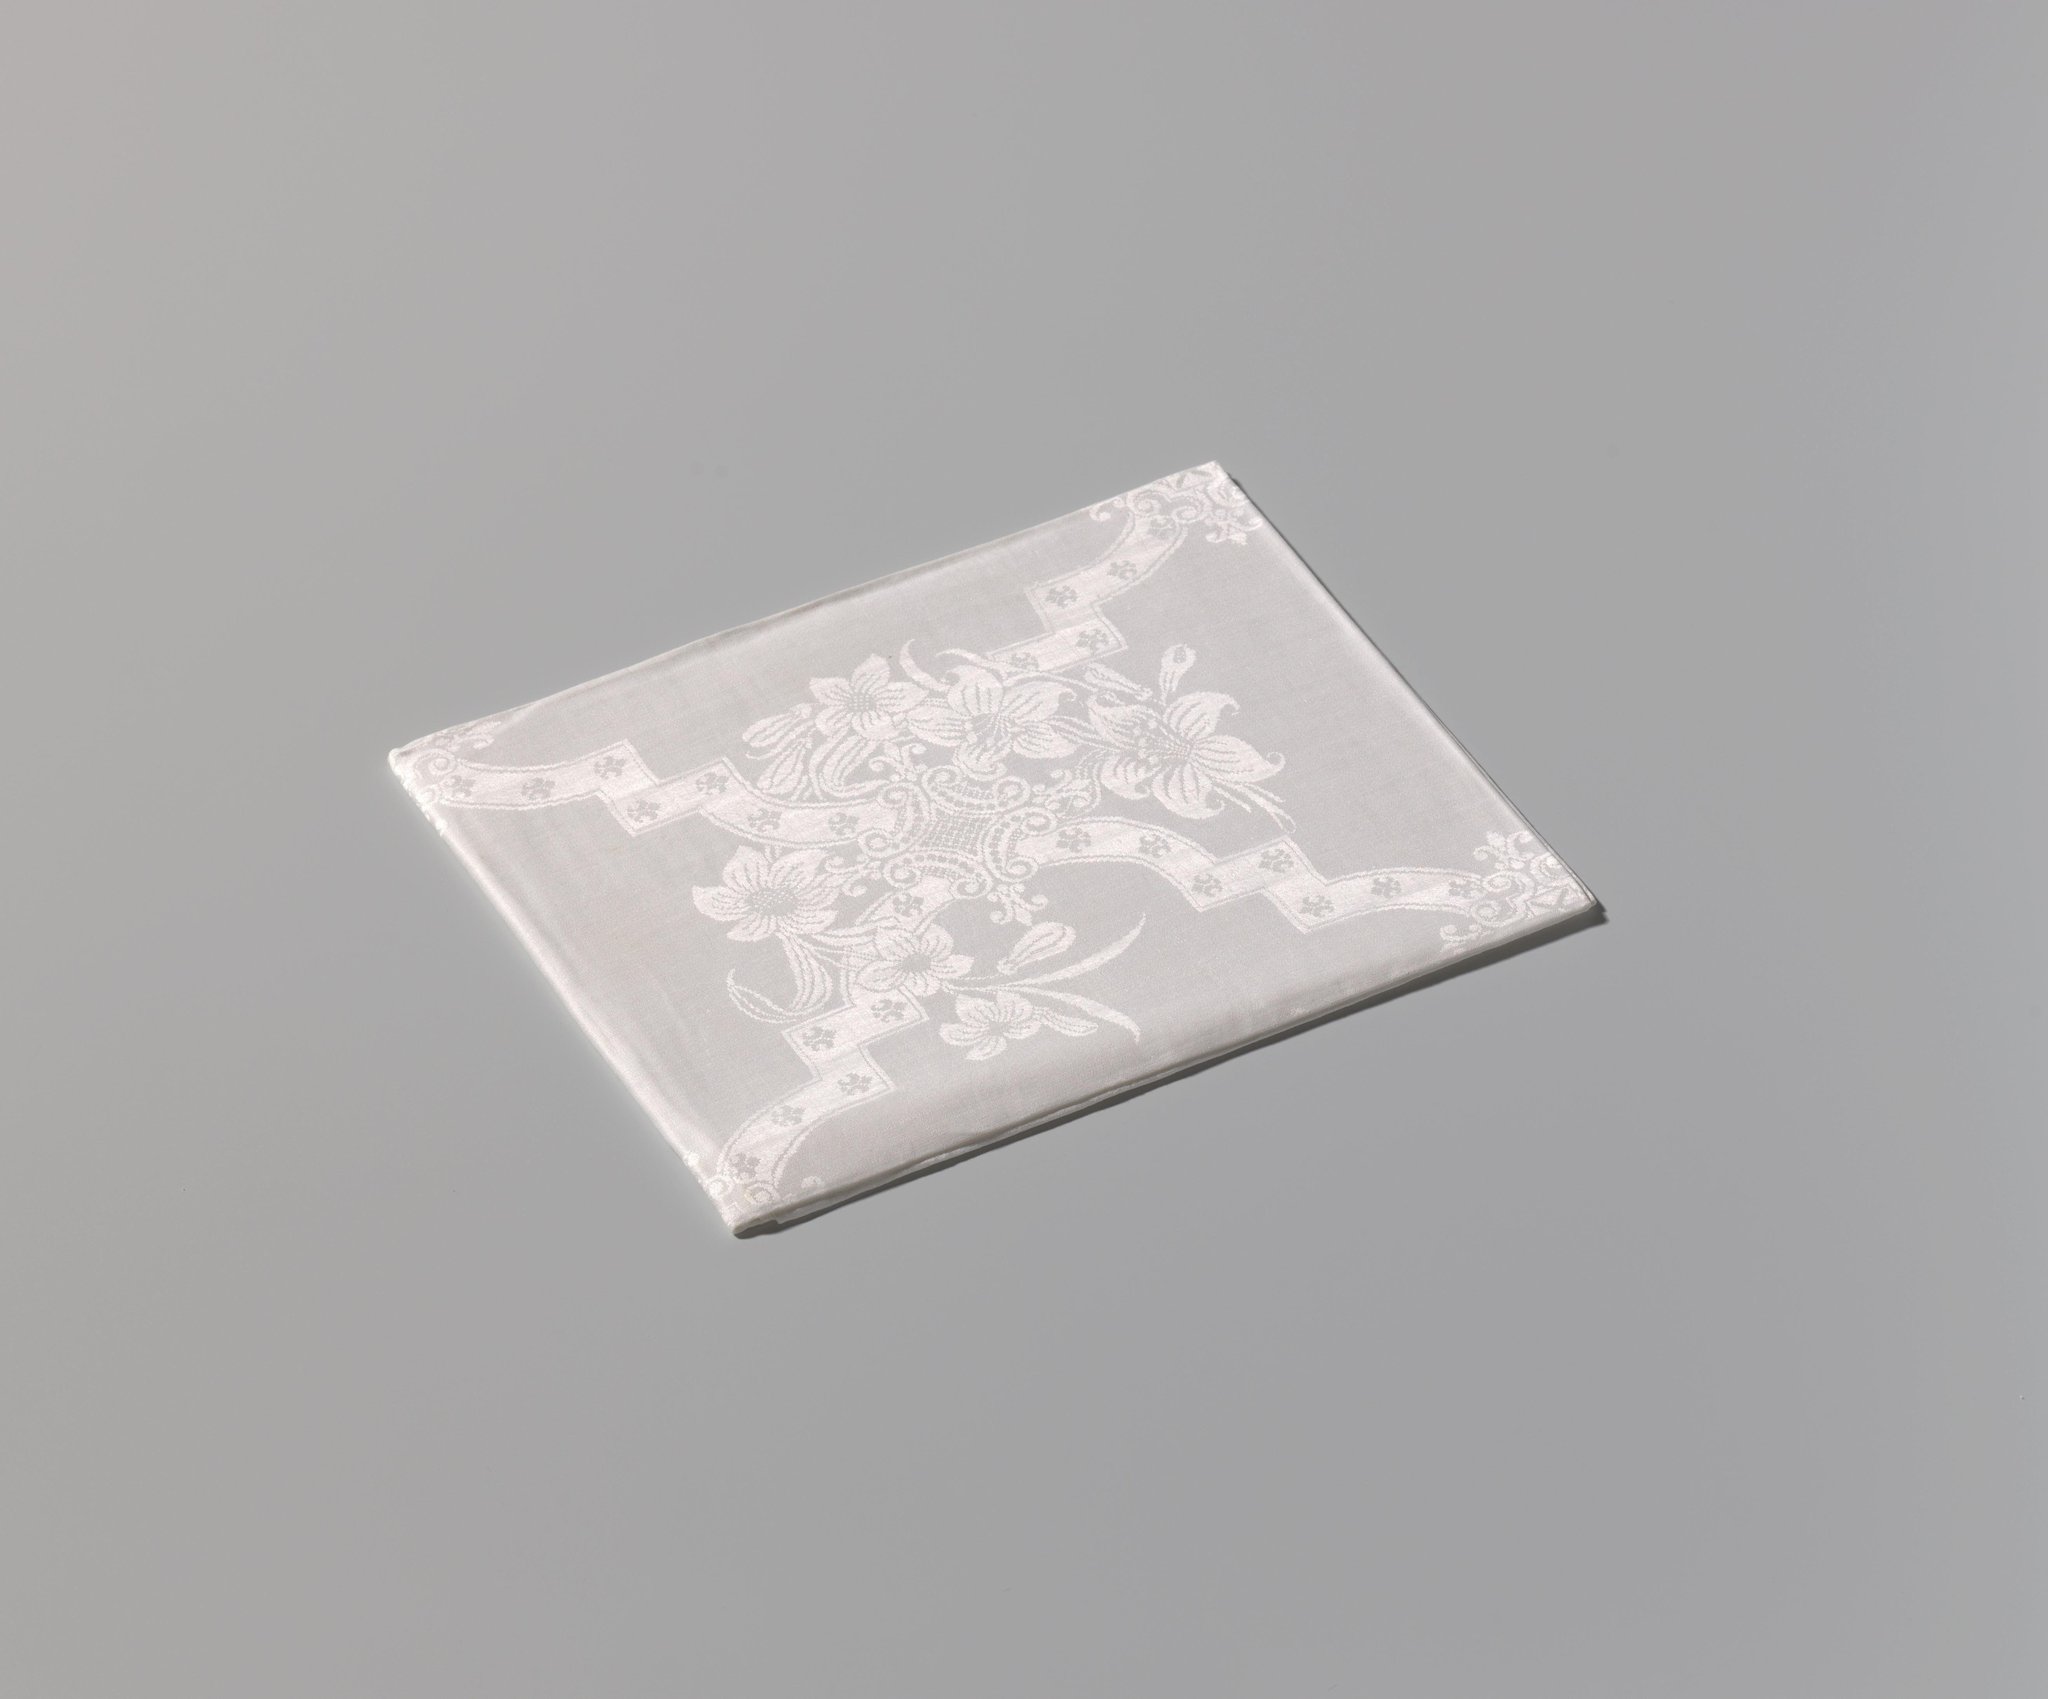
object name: napkin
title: Servet met fleurs de lys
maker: Anonymous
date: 1700-1710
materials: linen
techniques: damask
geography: dresden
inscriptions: label: ‘R.M. A'dam’, mark: ‘24’, mark: ‘BLS’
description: Servet van linnendamast met fleurs de lys. Slingerende banden vormen in de hoogte gerekte velden. De banden bestaan uit rechte en ronde delen, gevuld met kleine fleurs de lys; op de raakpunten een slingerende tak met leliën. De rand, alleen aan de buitenzijde omlijnd met fijne zigzagzomen en rolwerk met rastervulling, vertoont dicht aaneengesloten bloemboeketten, in de hoeken naar het midden gericht en voortkomend uit een draagstuk, waarop een fleur de lys. Rondom: blokkenrand.